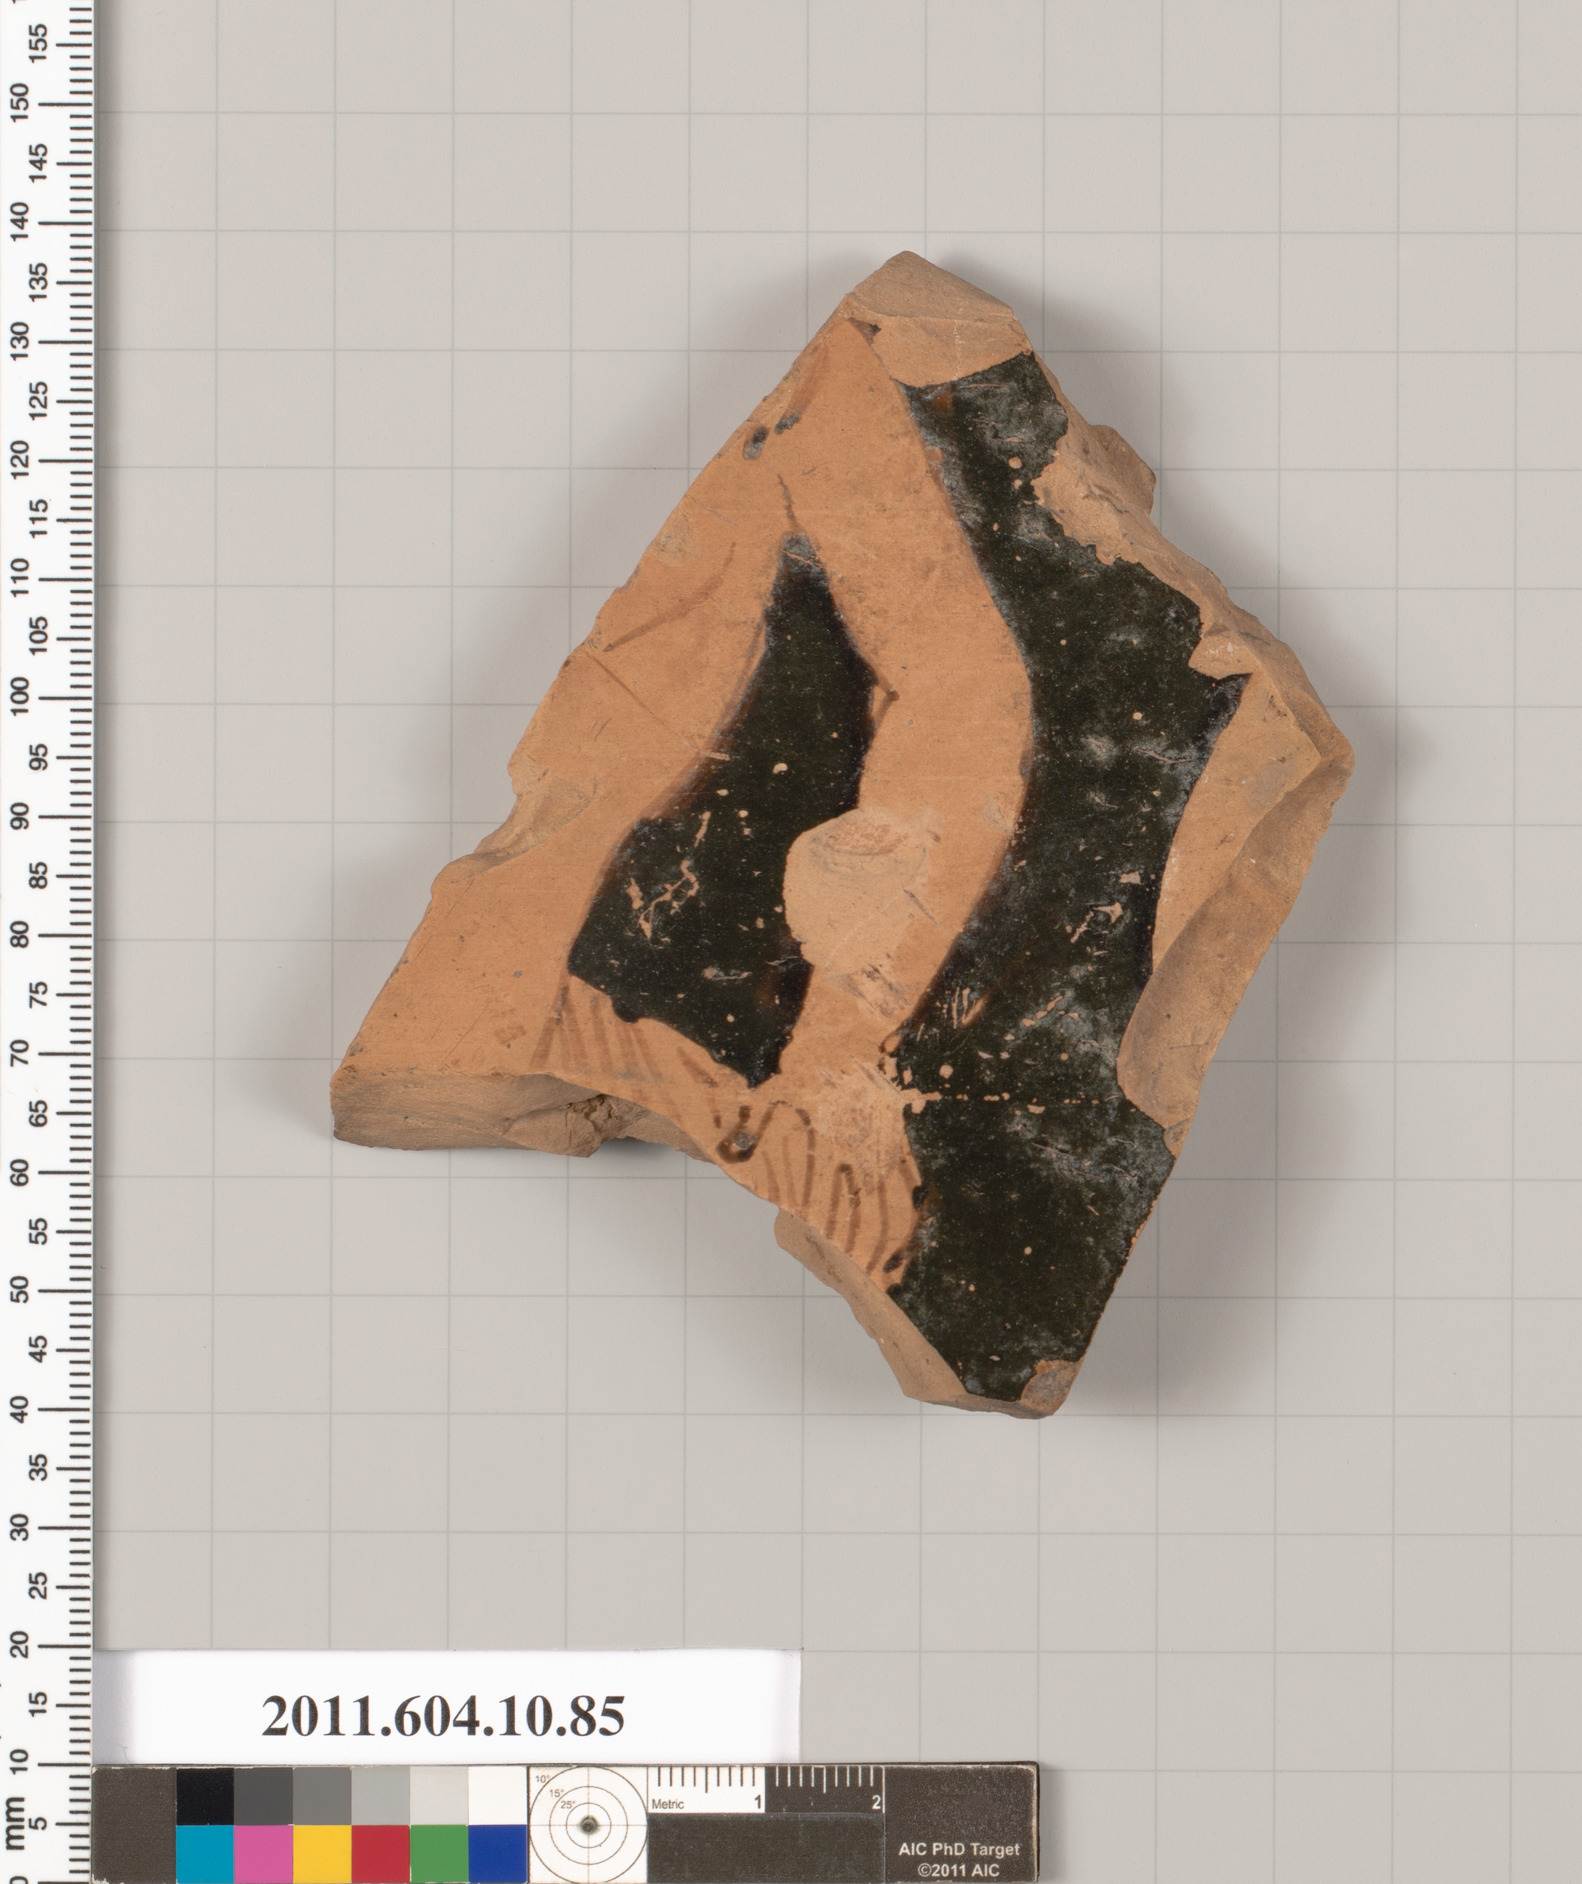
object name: krater fragment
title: Terracotta fragment of a krater (deep bowl)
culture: etruscan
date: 400-301 BCE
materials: terracotta